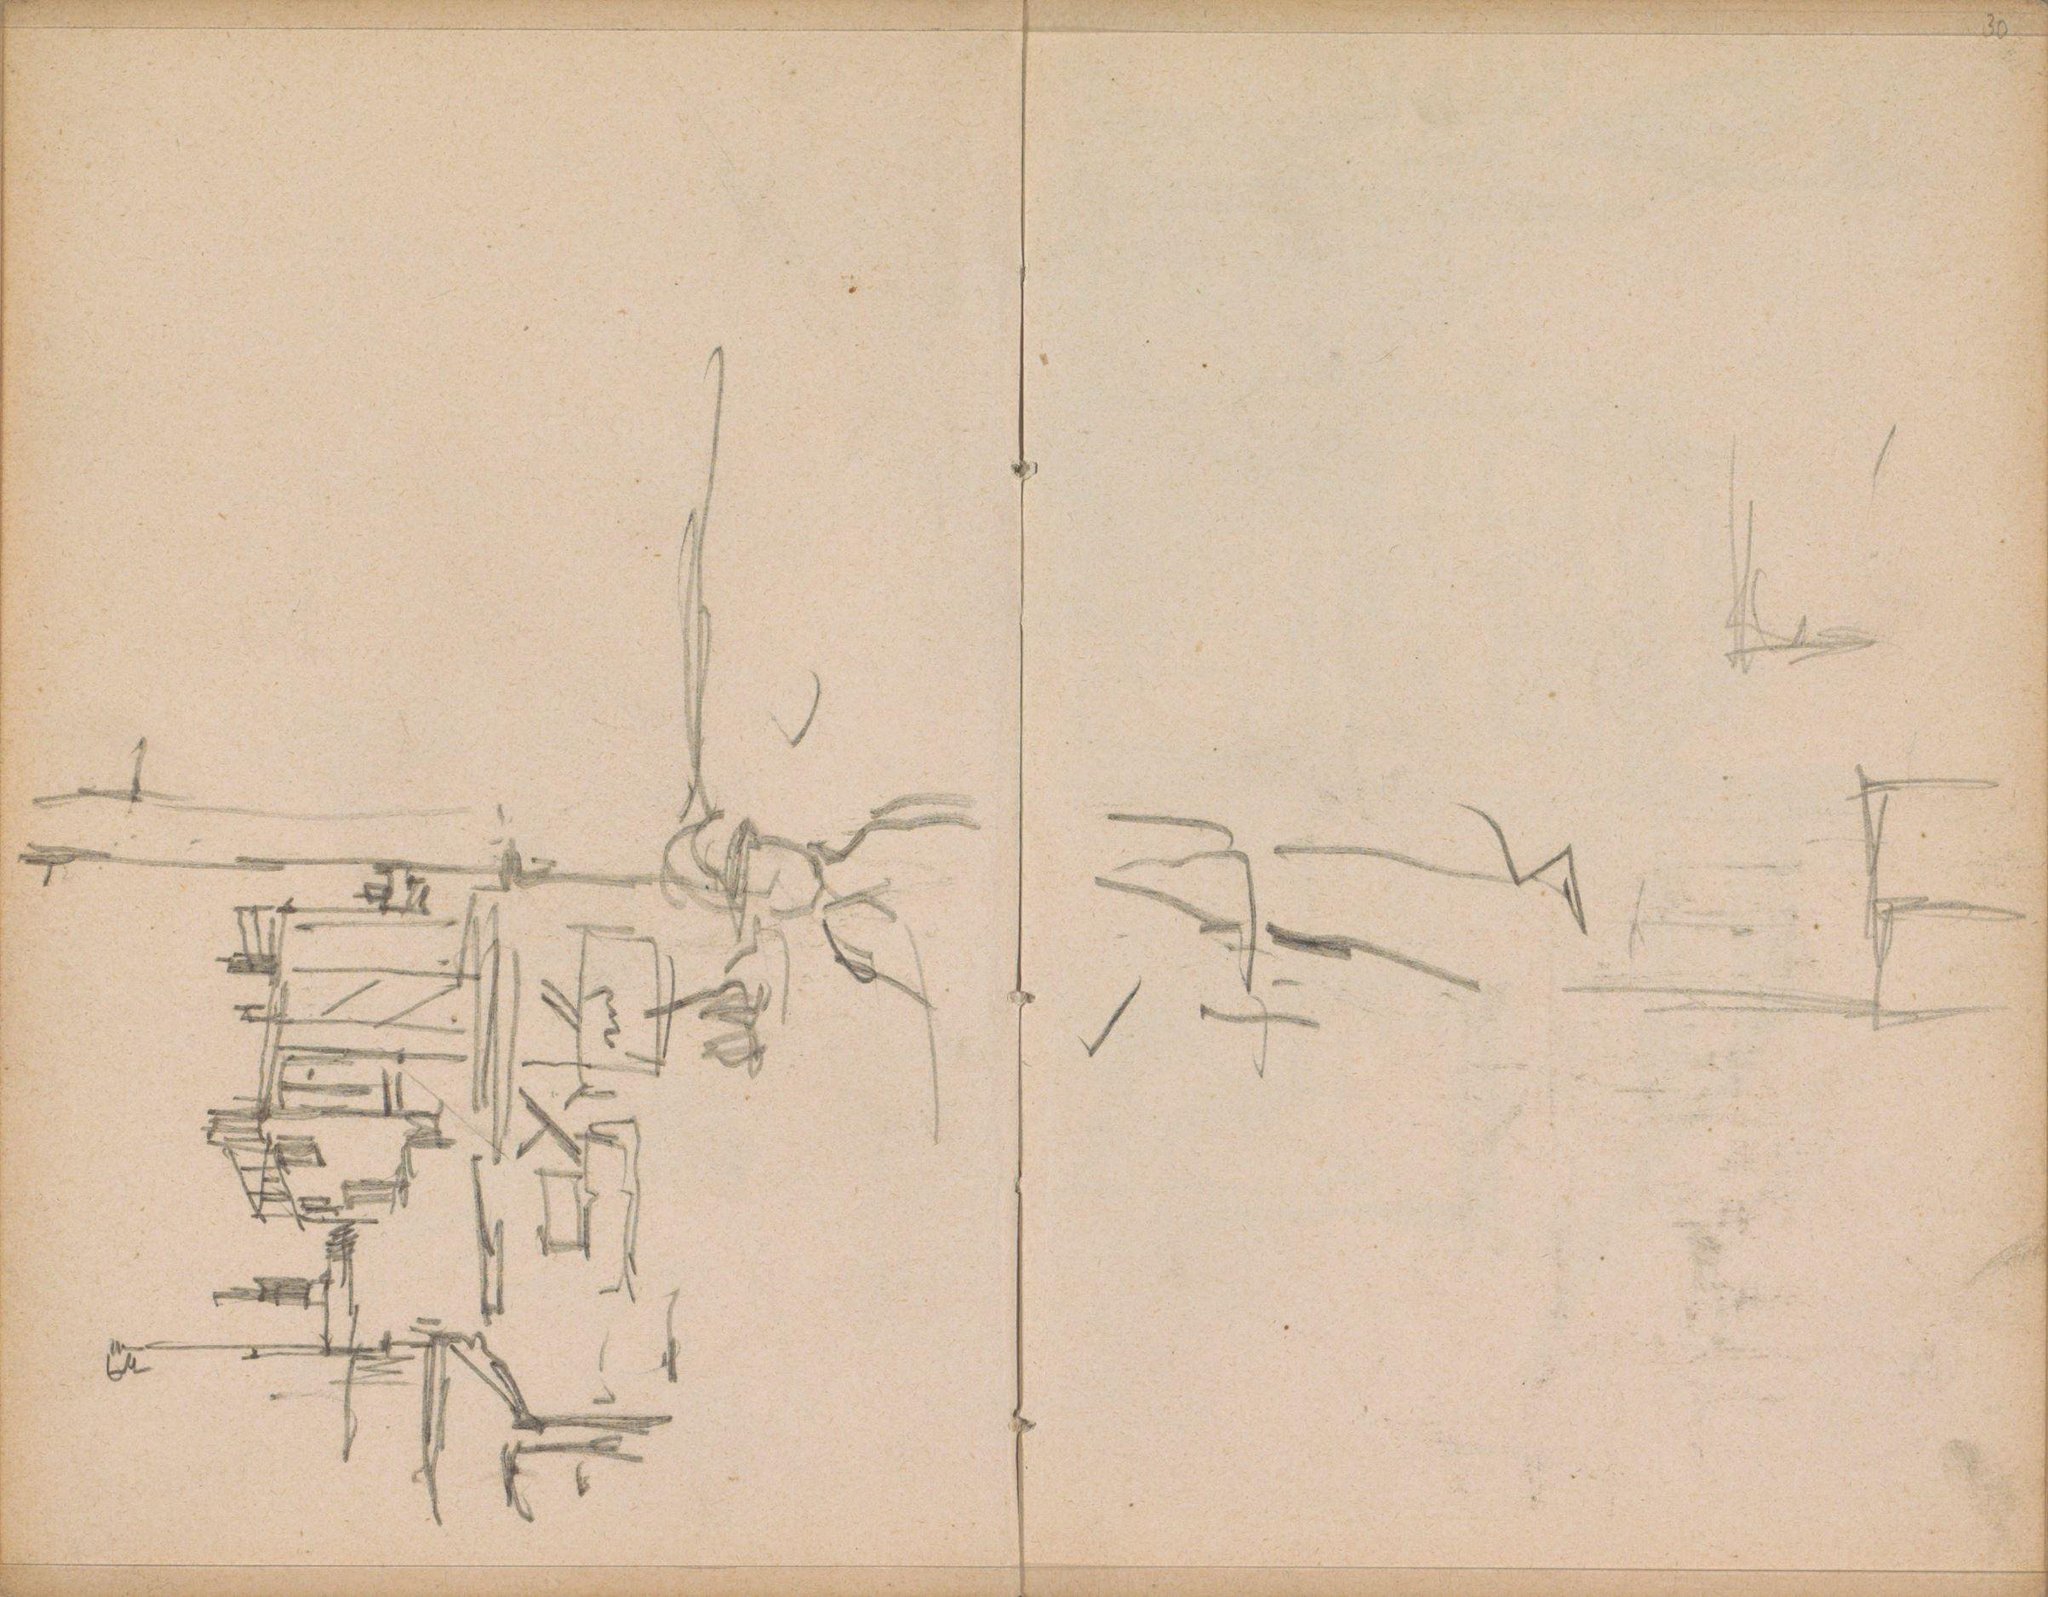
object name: sketchbook leaf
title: Figuur voor gebouwen, mogelijk in Amsterdam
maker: george hendrik breitner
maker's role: draughtsman, painter, print maker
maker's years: 1857-1923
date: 1886-1908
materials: paper, pencil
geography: amsterdam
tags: adult man, architecture, amsterdam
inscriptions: kleurnotitie, handgeschreven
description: Pagina 29 en pagina 30 uit een schetsboek met 46 bladen vervaardigd te Amsterdam, Haarlem en Antwerpen.